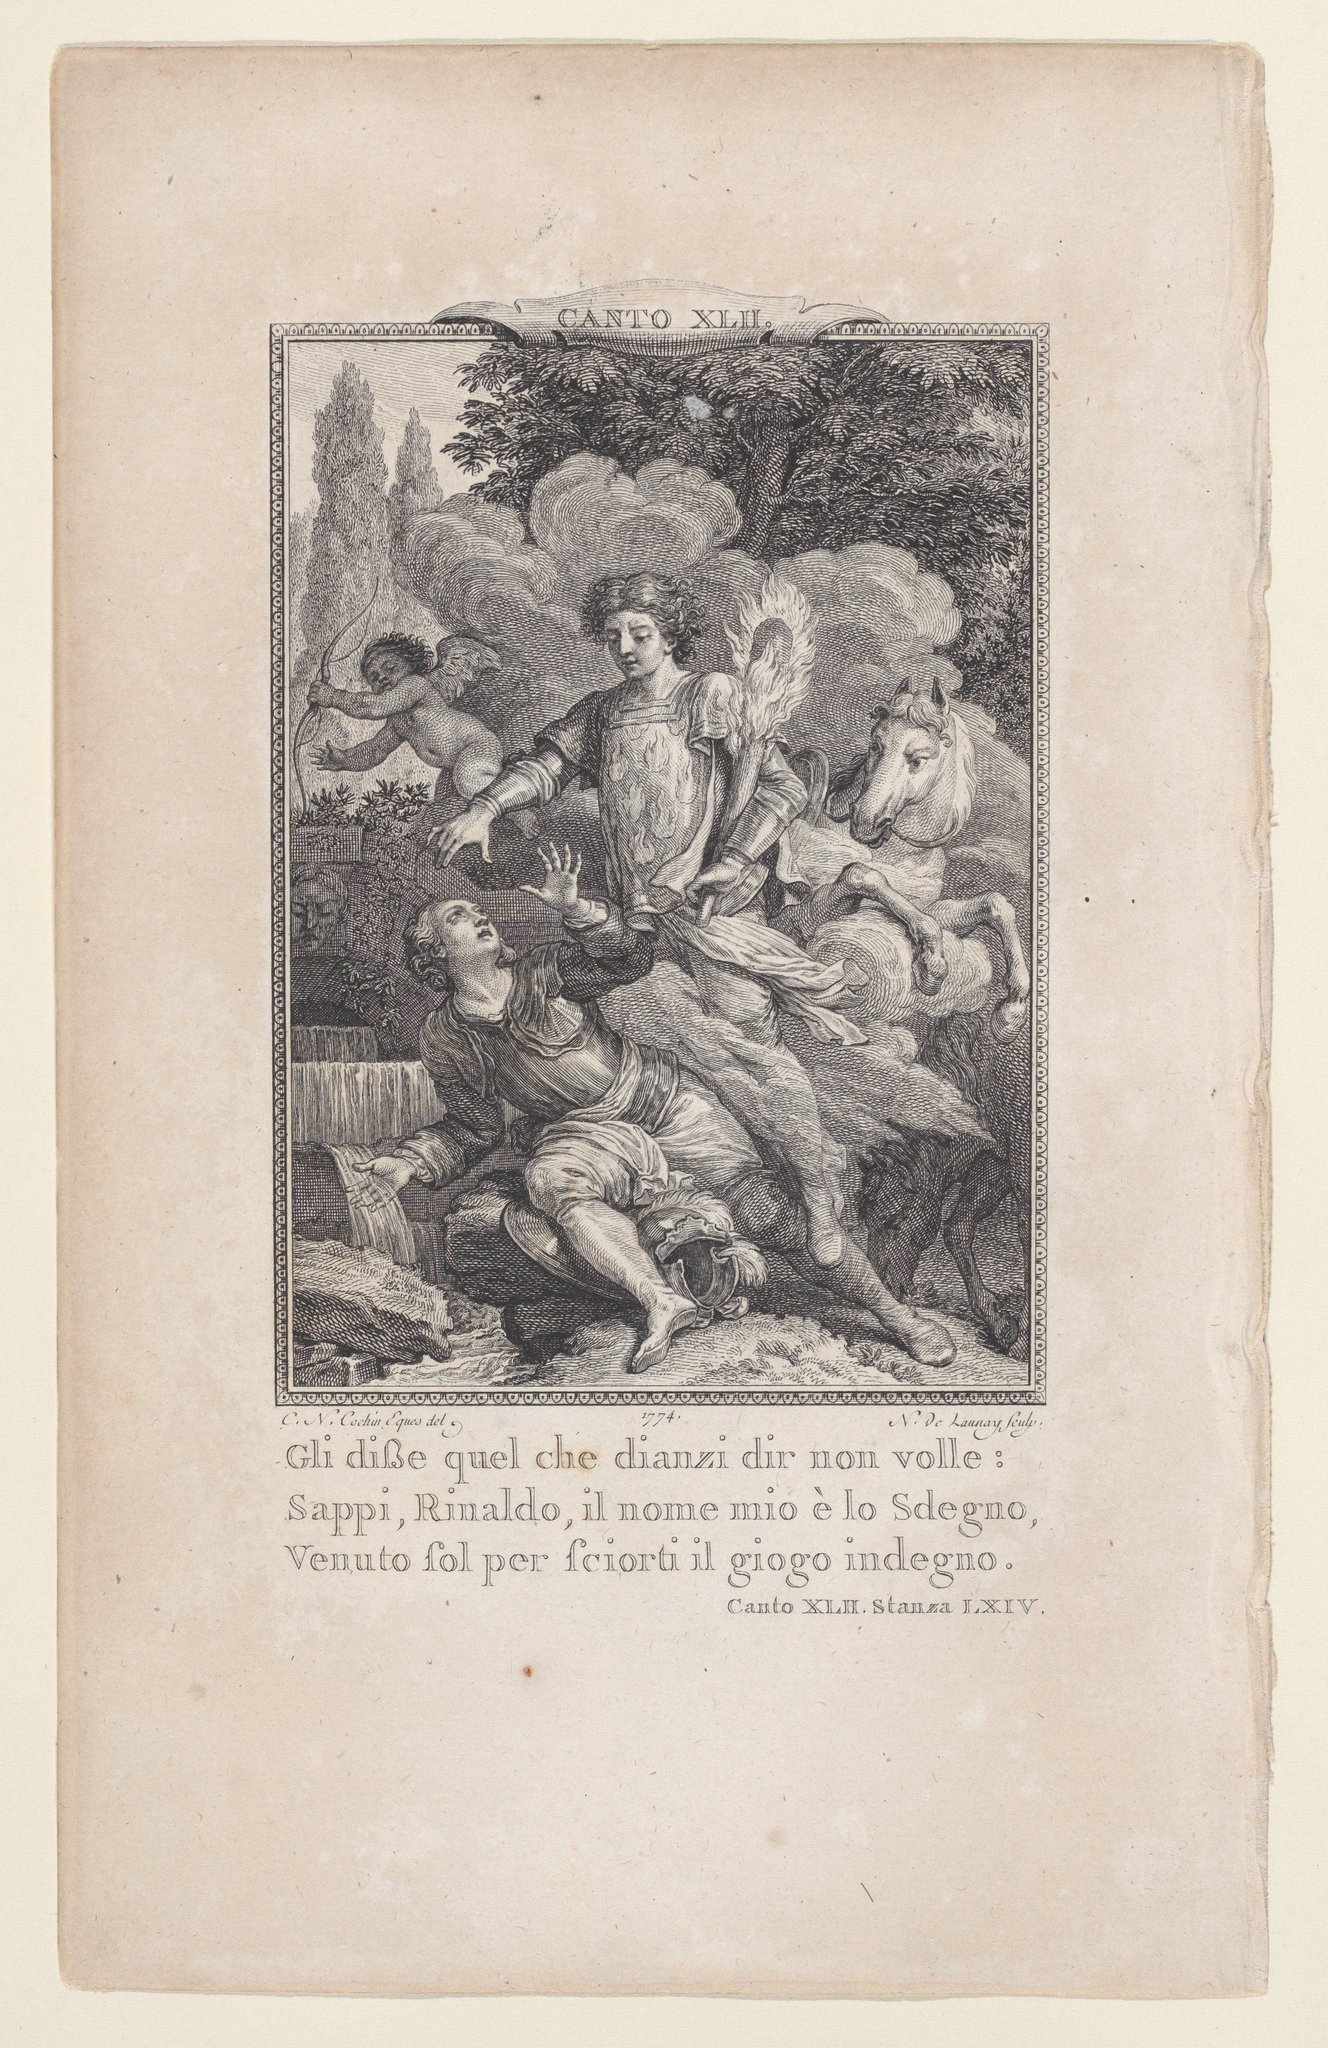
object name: print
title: Canto 42, Stanza 64, from "Orlando Furioso"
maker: nicolas de launay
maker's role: artist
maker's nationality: french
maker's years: 1739-1792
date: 1774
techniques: engraving, etching